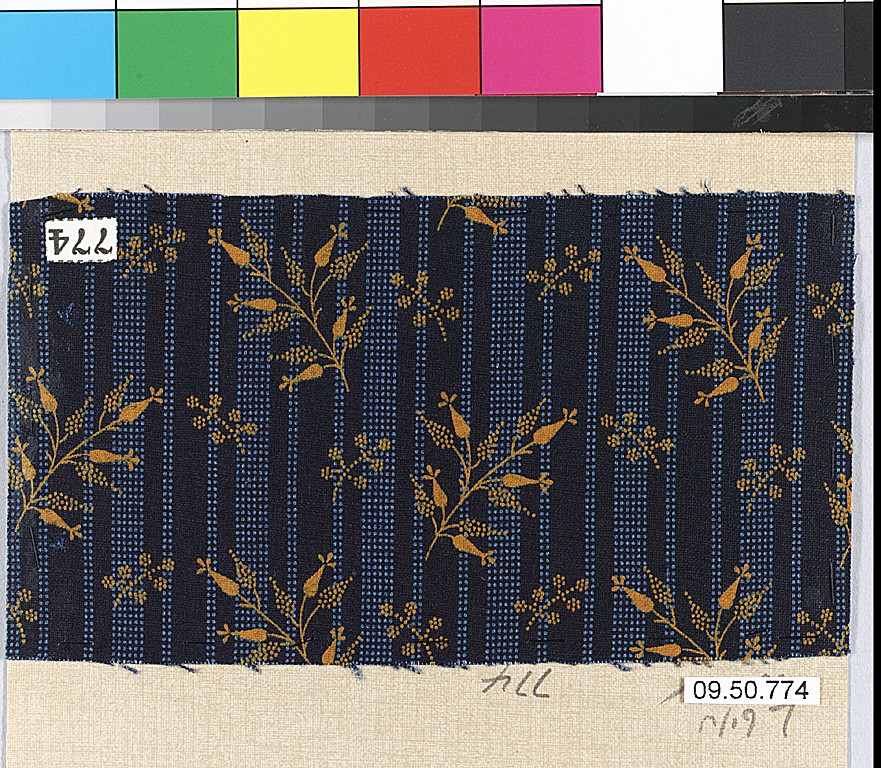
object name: piece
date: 1801-1900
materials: cotton